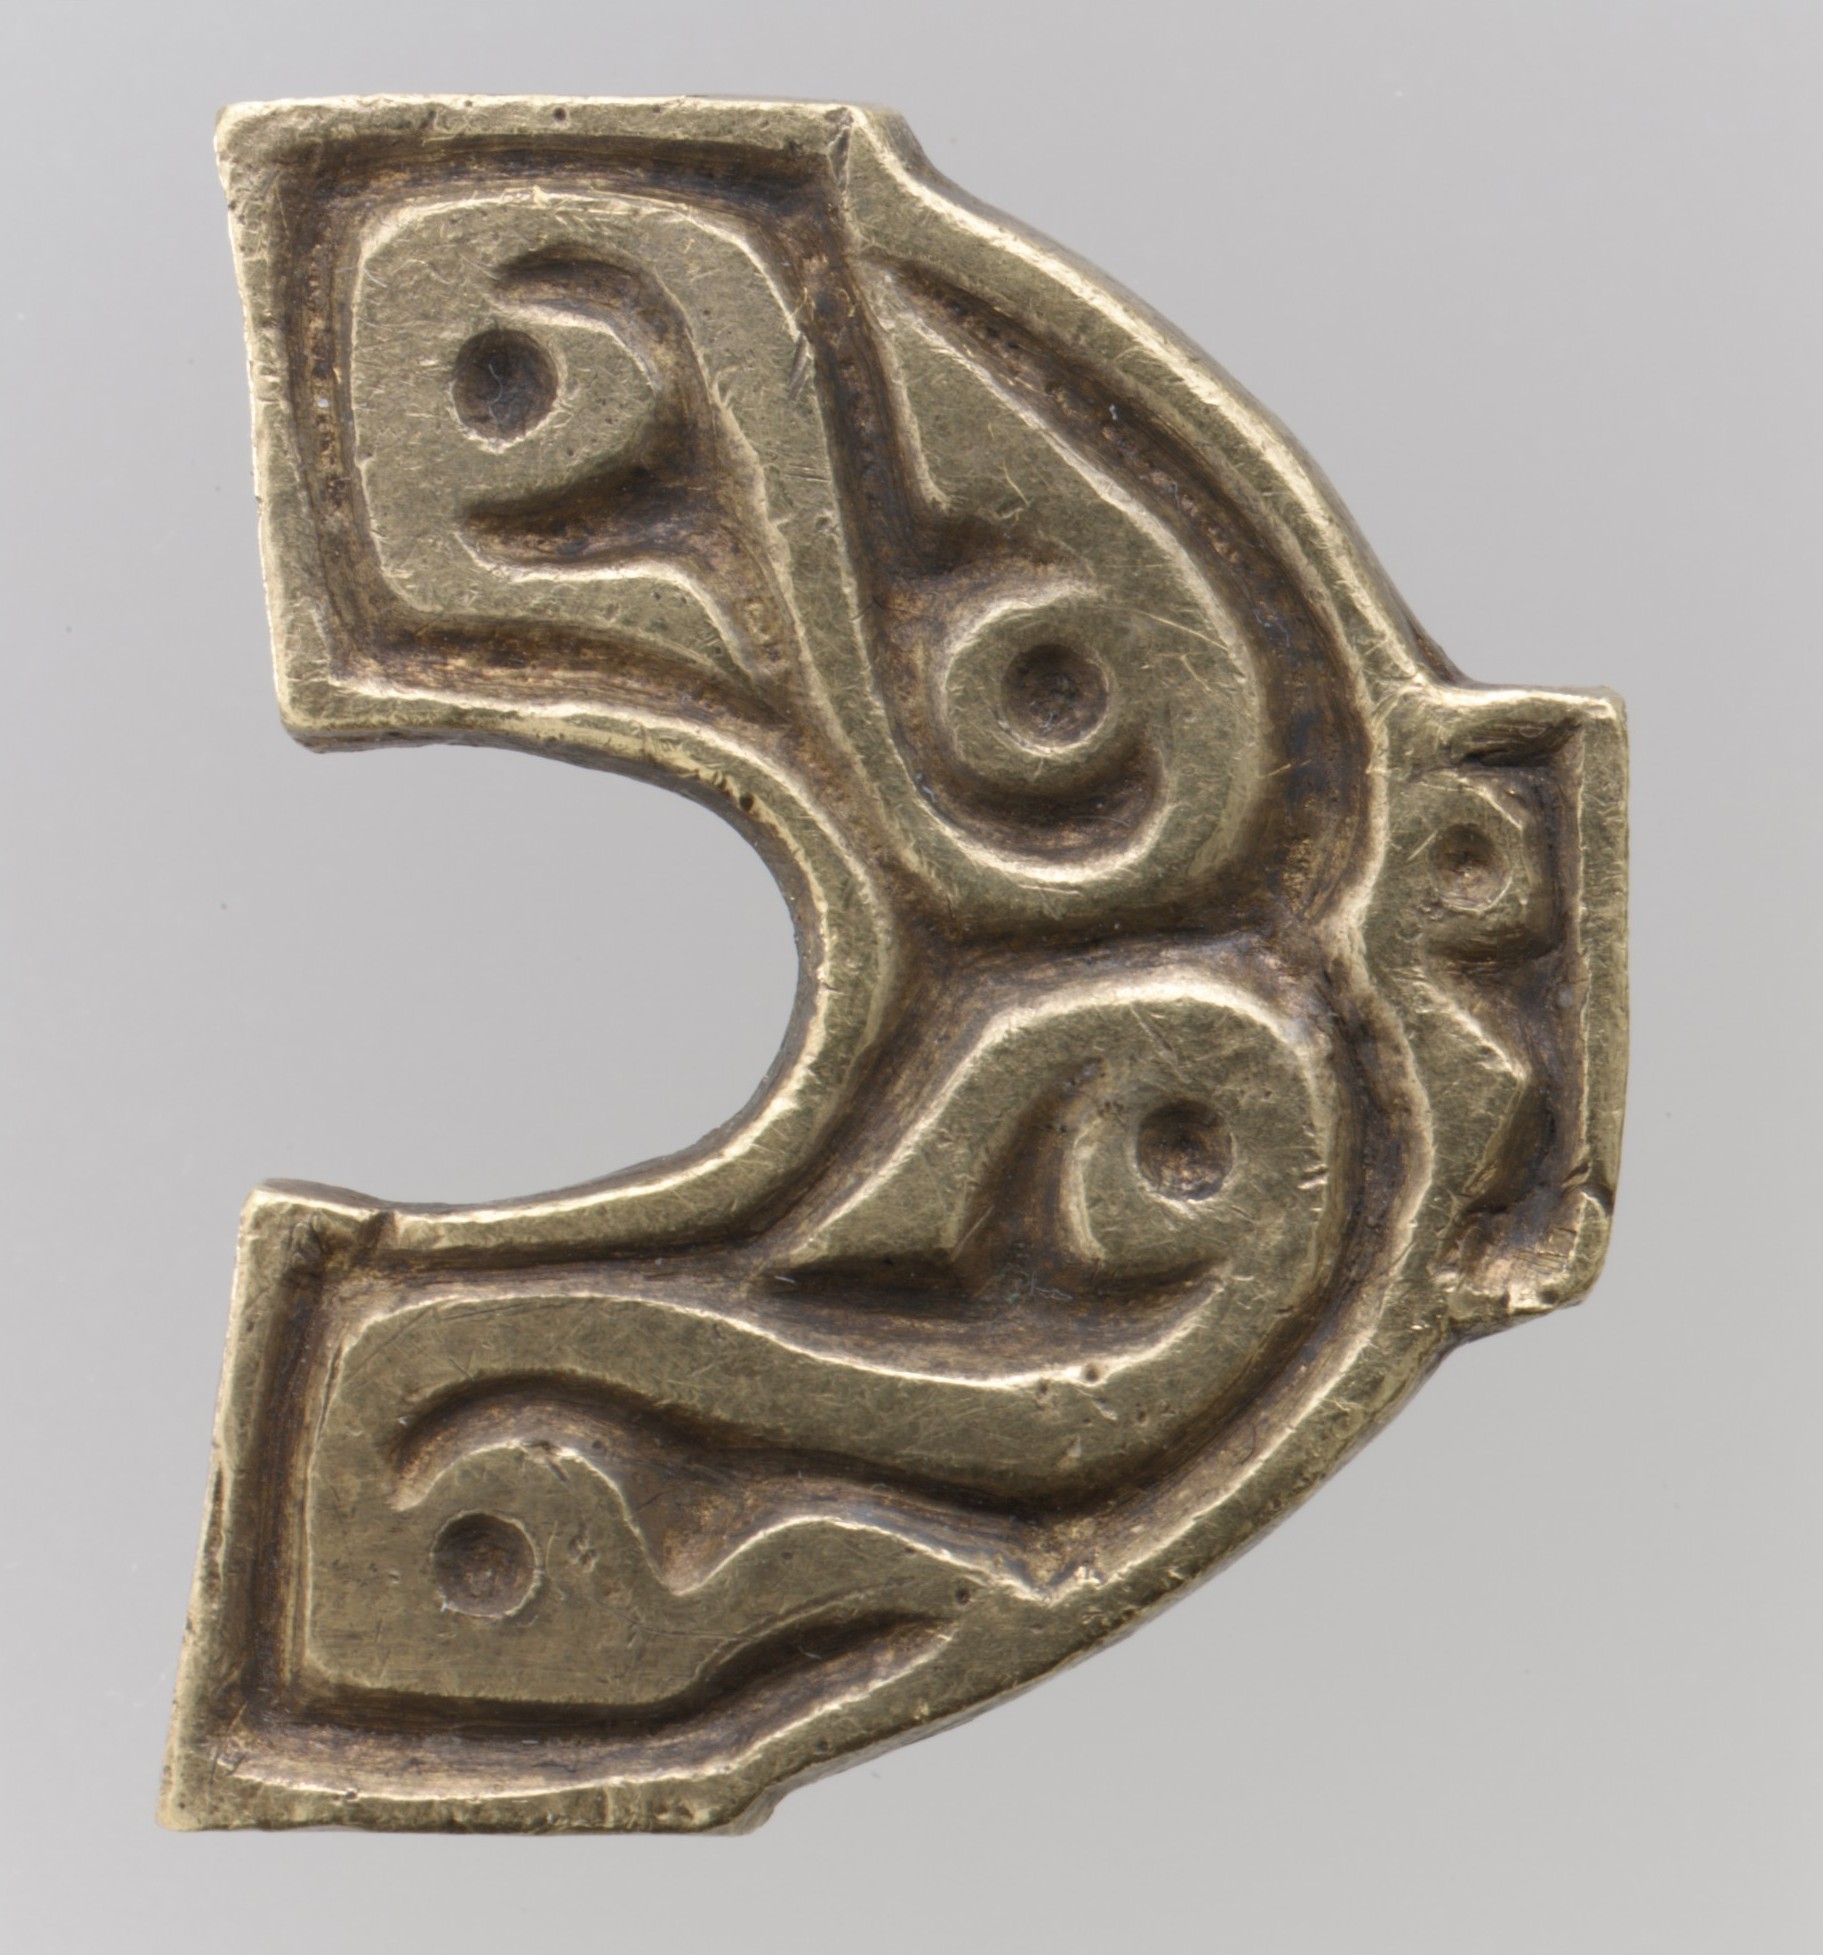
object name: garniture or mounting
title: Gold Belt-Hole Guard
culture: avar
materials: gold